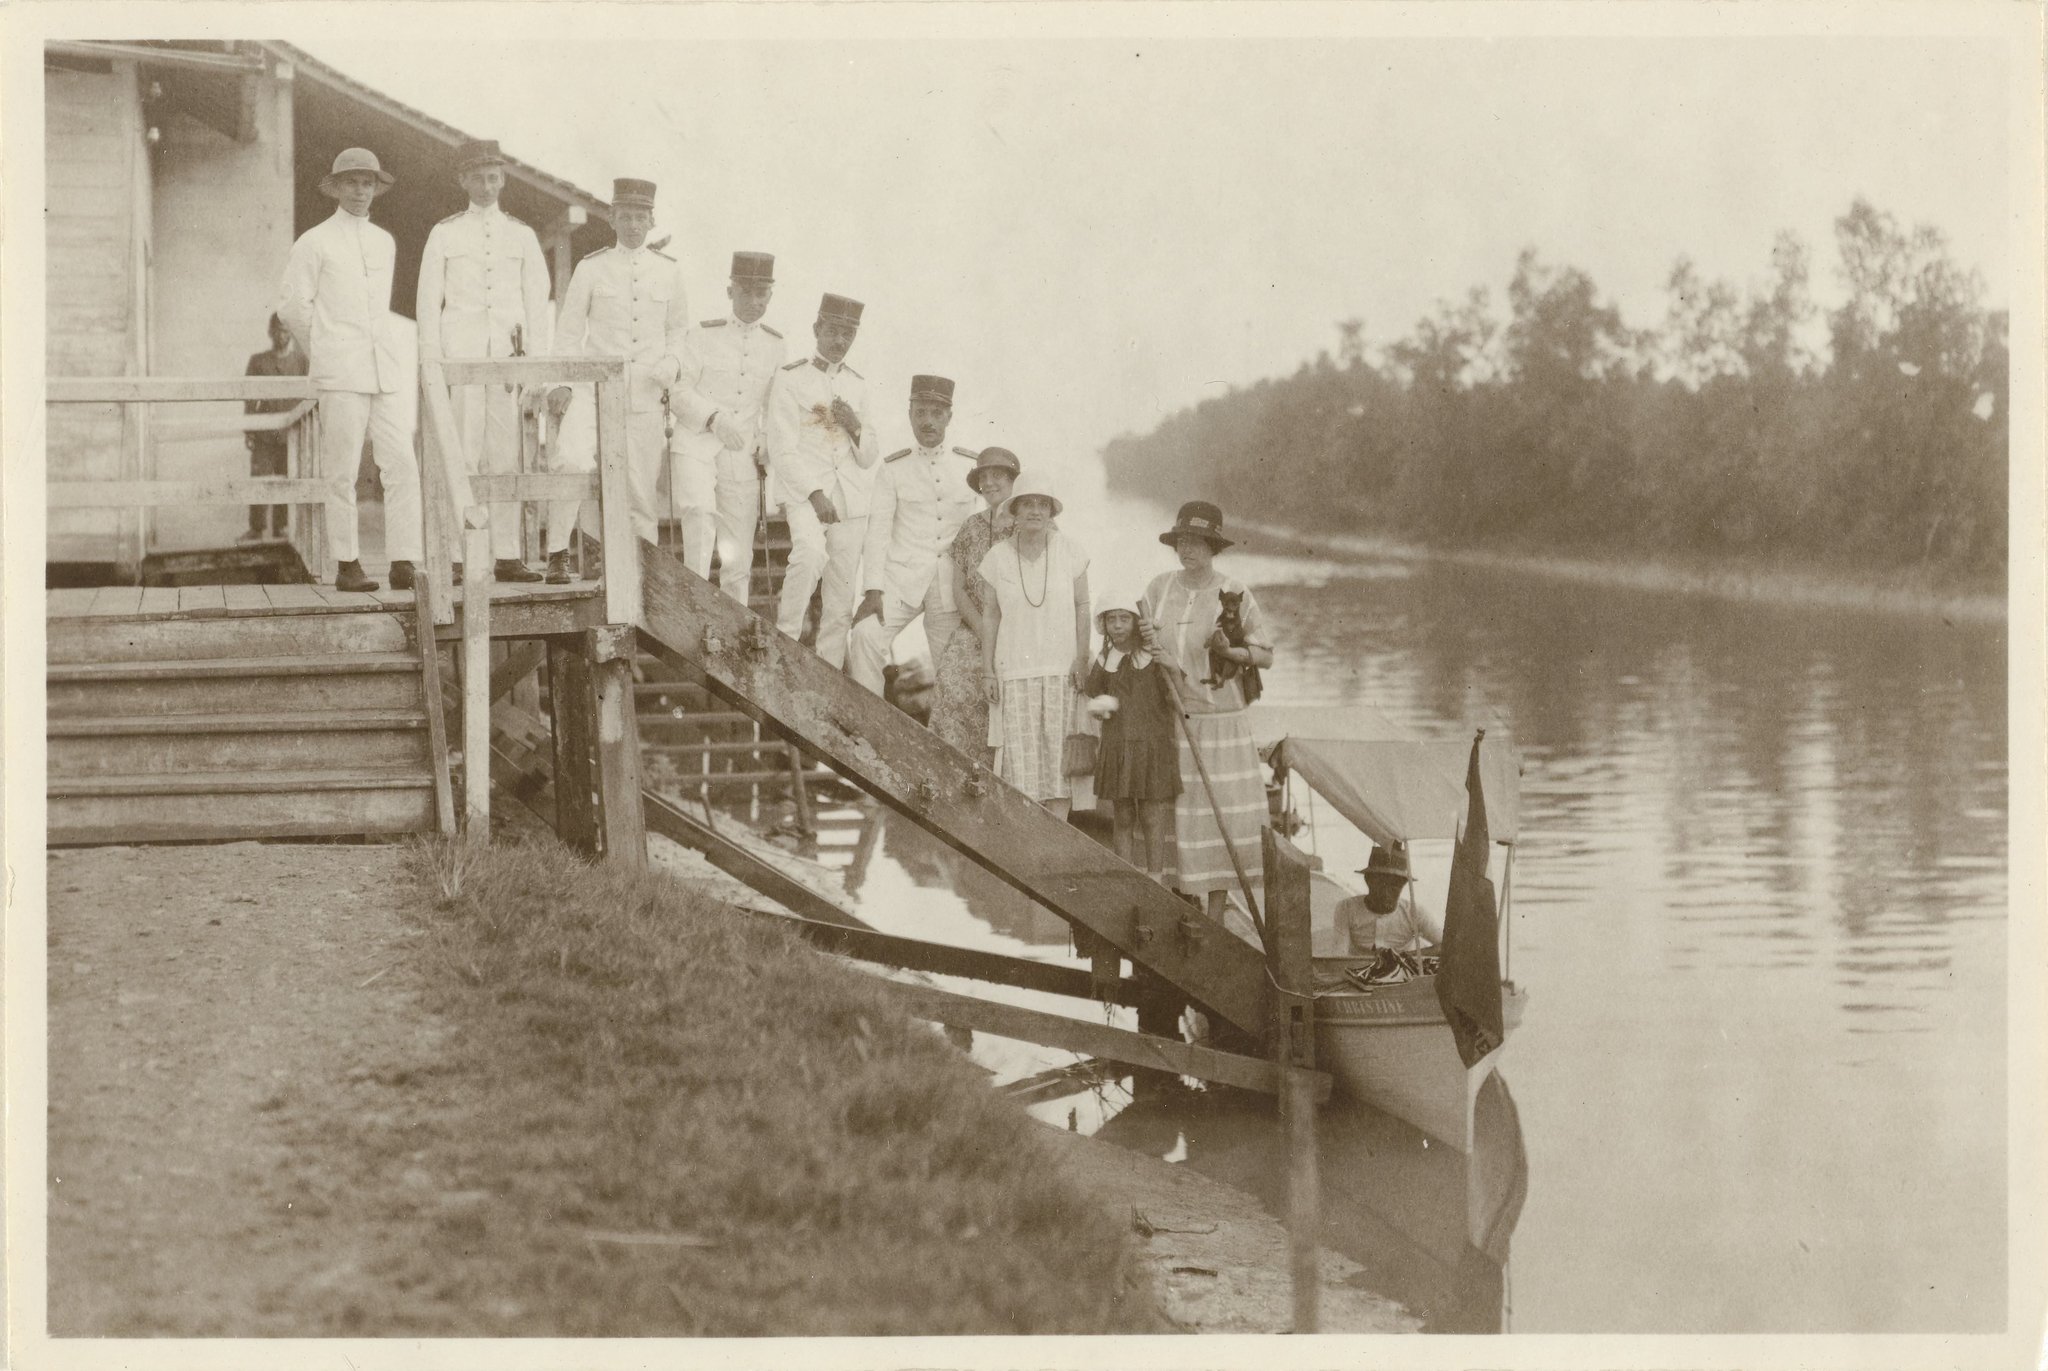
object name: photograph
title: Groepsfoto op een stijger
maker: Anonymous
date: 1920-1940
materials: photographic support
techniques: gelatin silver print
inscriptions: inscription: ‘4 van links Klaas Kleiterp 1e vrouw Tine Vermeulen’